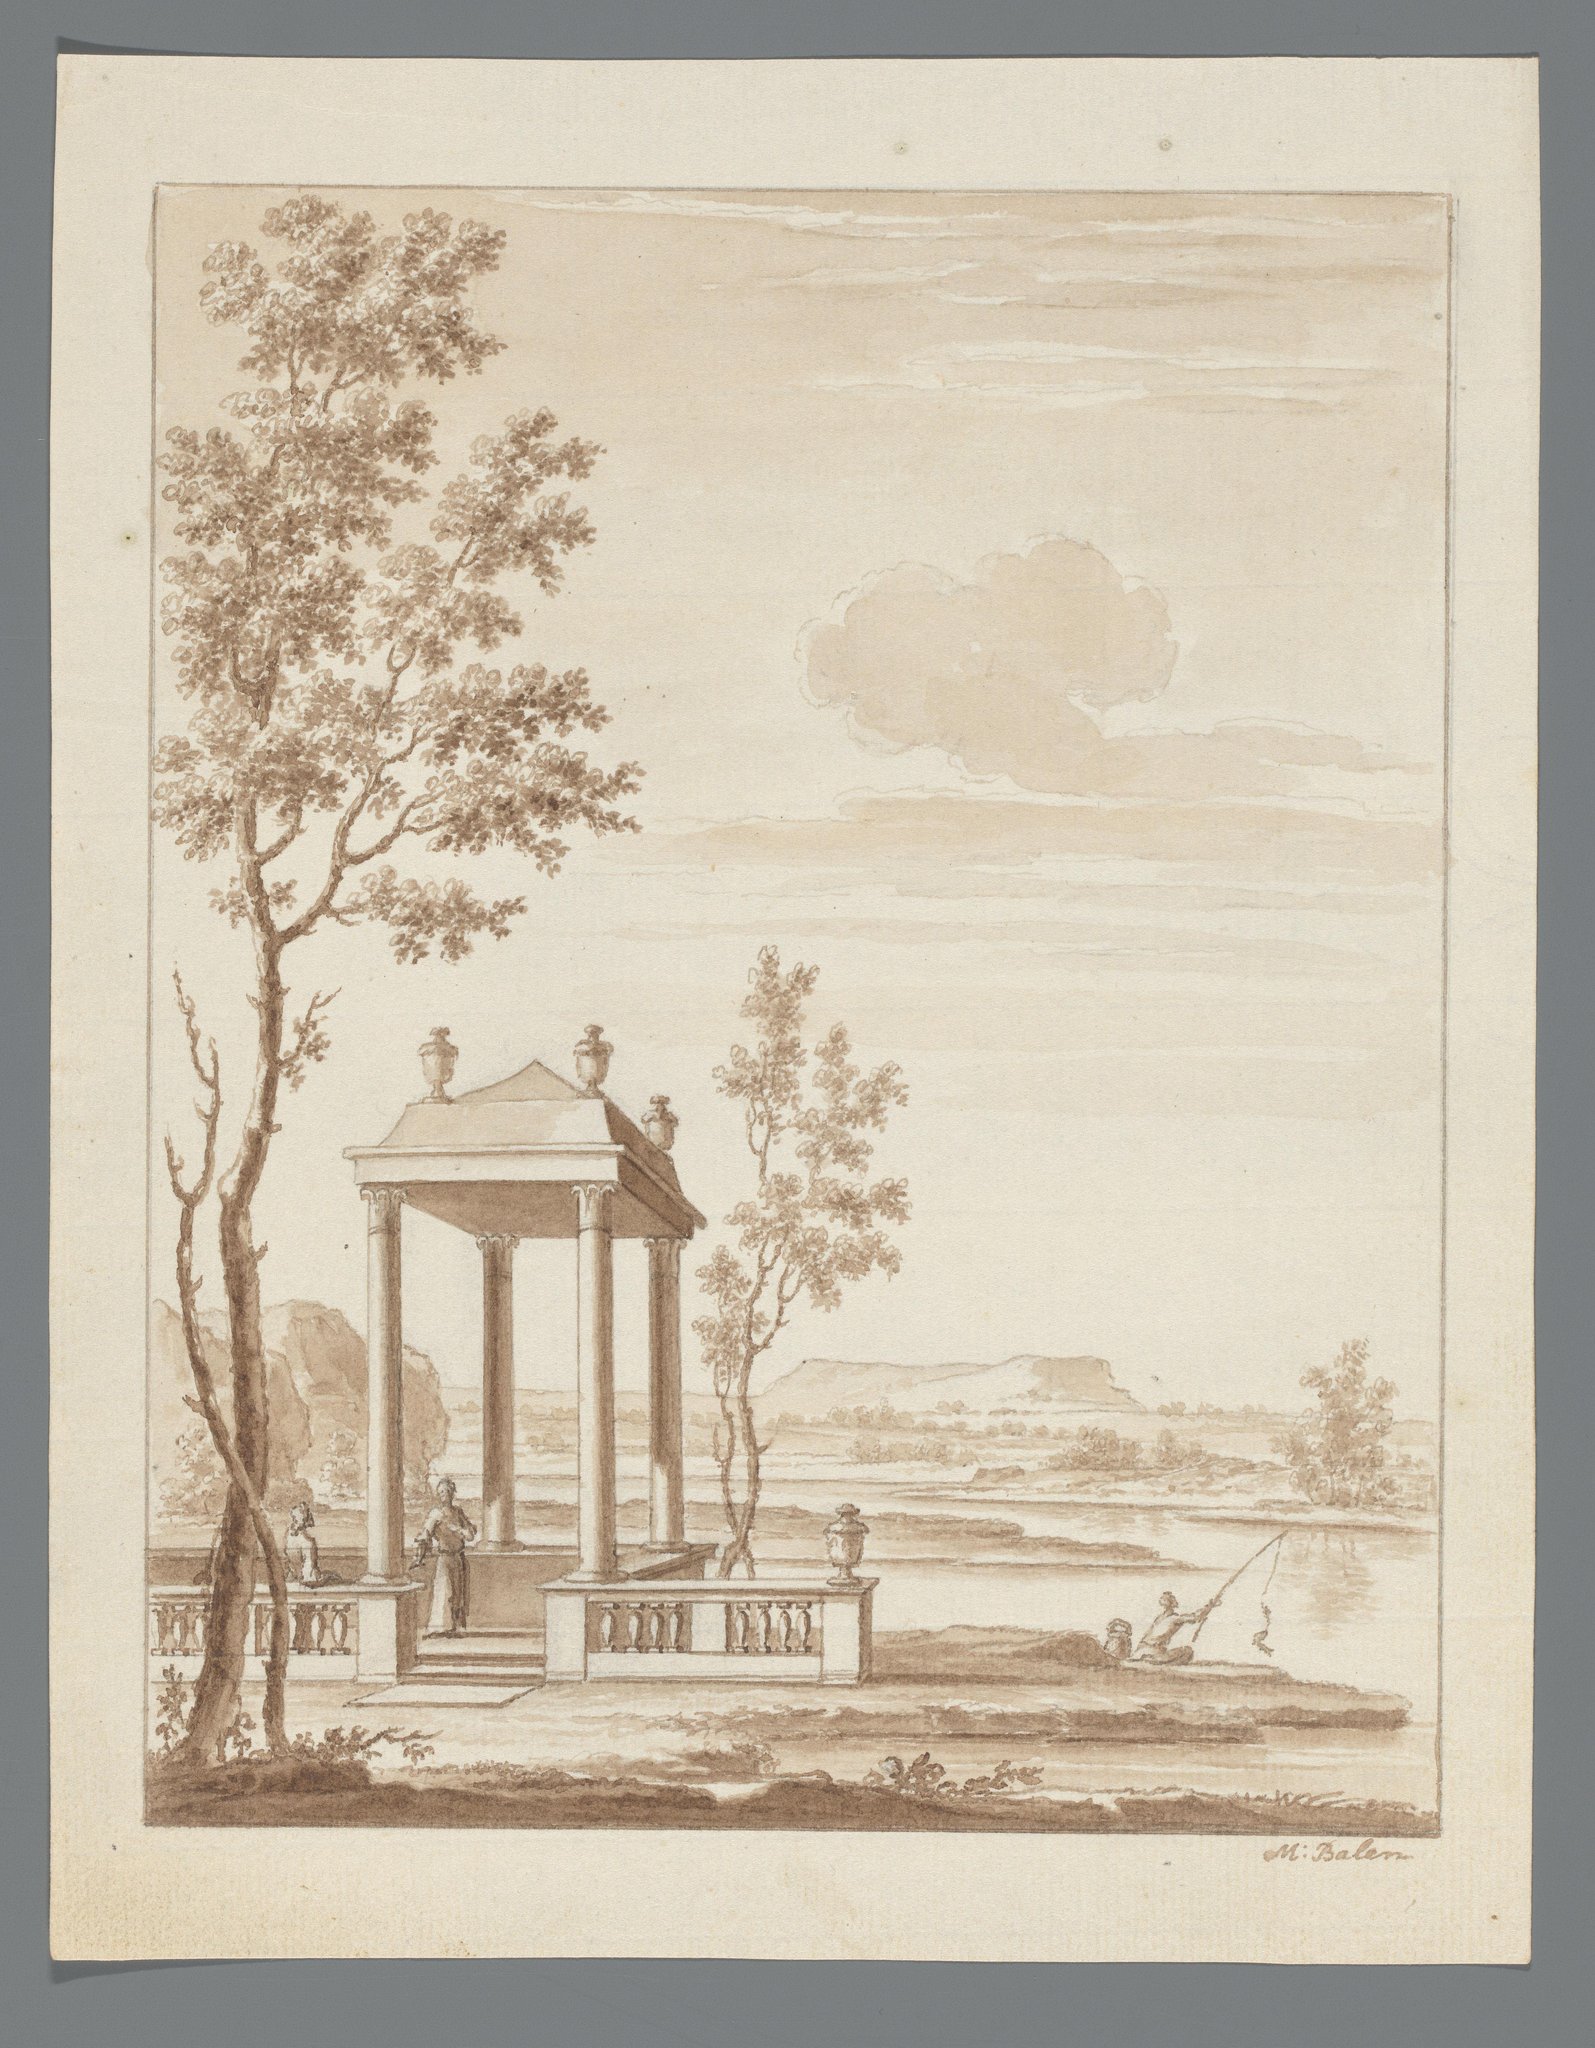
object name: drawing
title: Galerij aan het water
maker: matthijs balen (1684-1766)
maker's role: draughtsman, painter, print maker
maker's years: 1684-1766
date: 1694-1766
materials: paper, pencil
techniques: brush, pen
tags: city-view, and landscape with man-made constructions, rural housing, e.g. country-house, villa, cottage, gallery (spacious corridor)